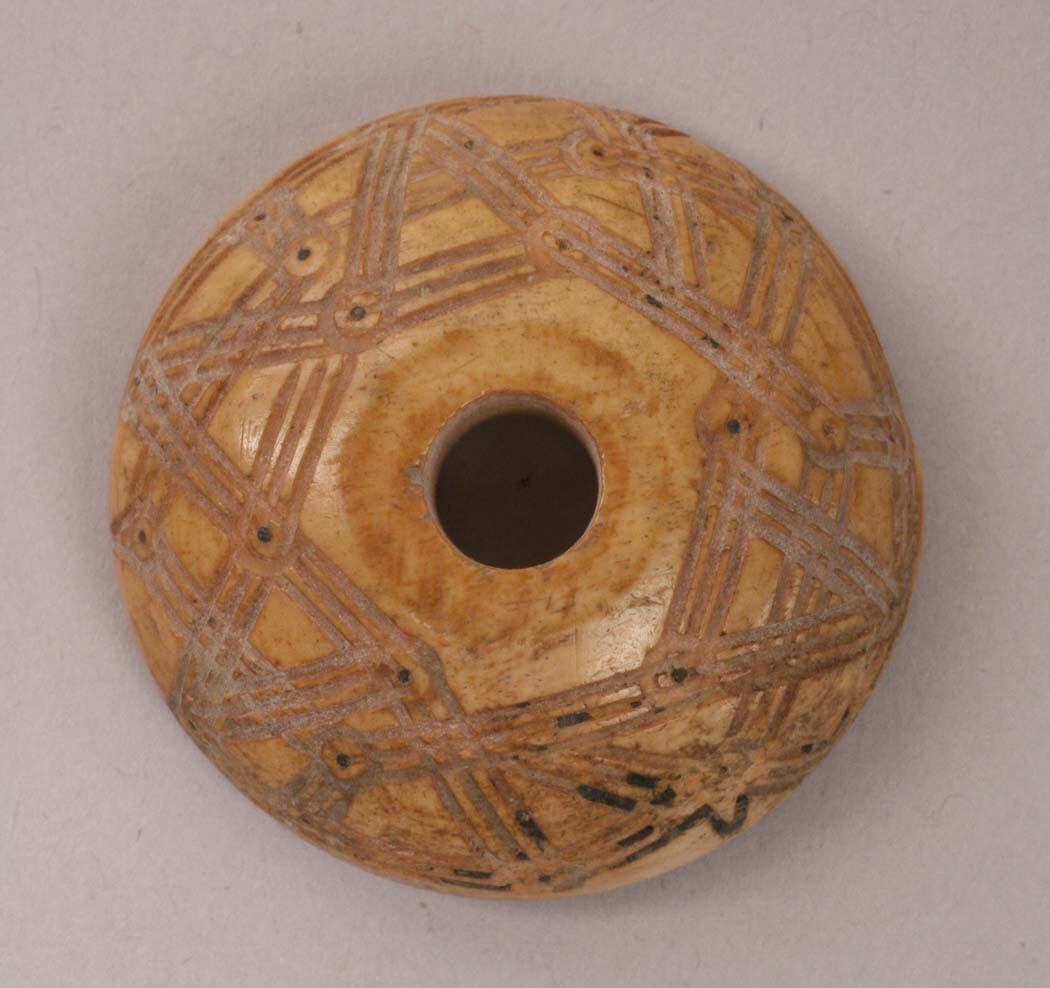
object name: spindle whorl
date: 701-1000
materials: bone, paint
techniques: incising, inlay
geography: egypt